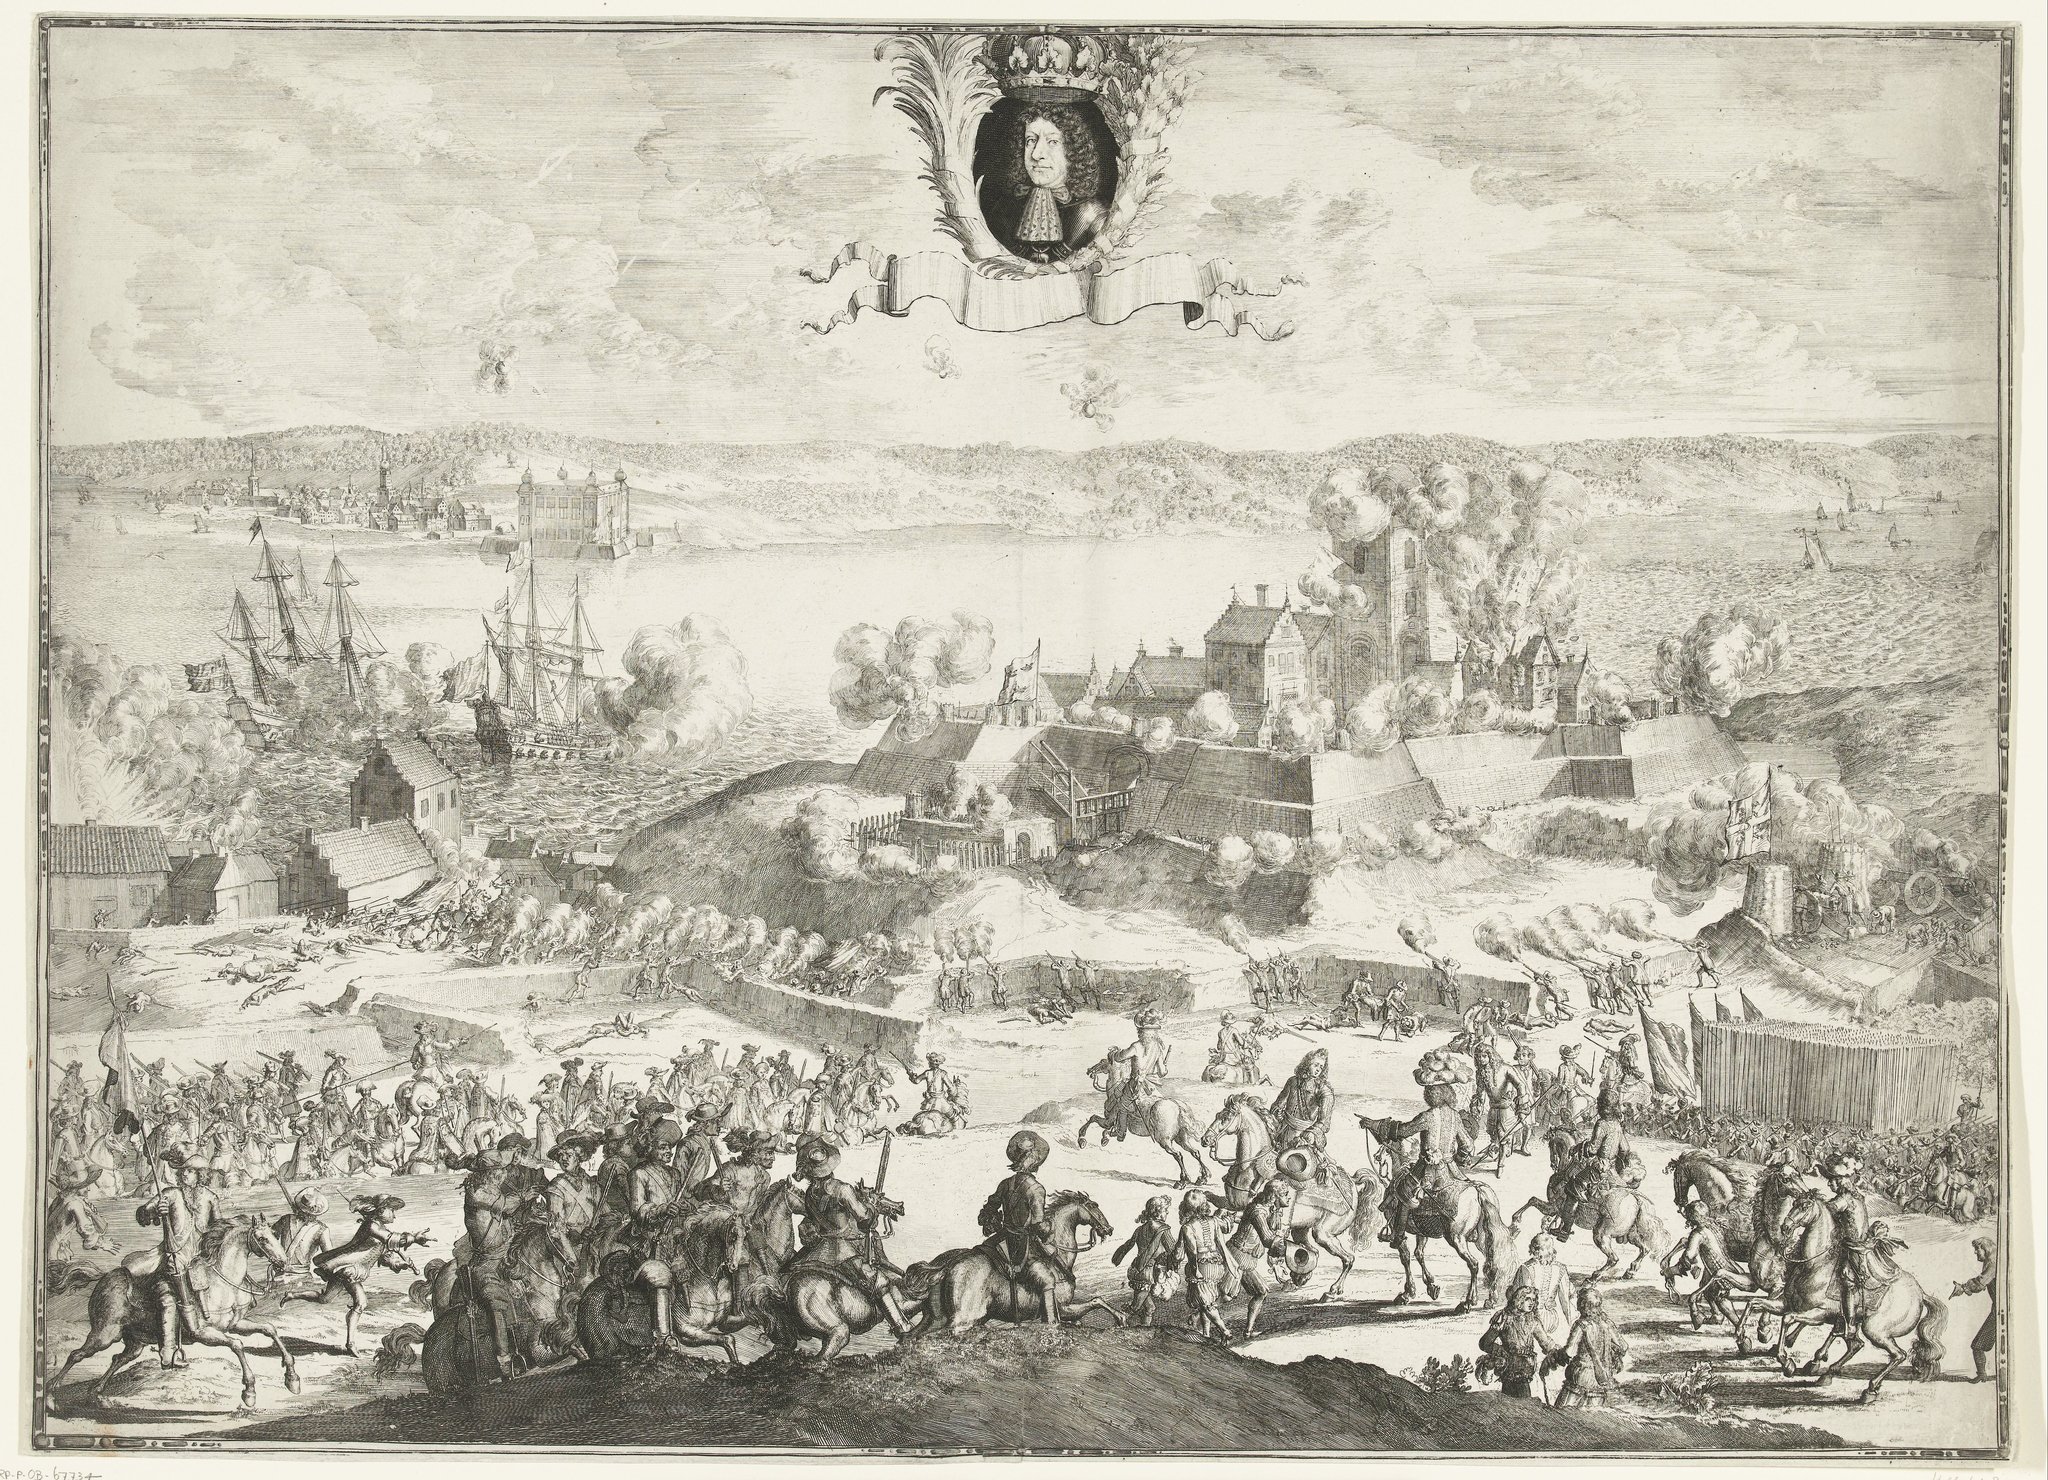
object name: print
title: Verovering van Helsingborg (Elsenburgh) door het Zweedse leger, 1677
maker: romeyn de hooghe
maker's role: draughtsman, goldsmith, painter, print maker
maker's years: 1645-1708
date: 1677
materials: paper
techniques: etching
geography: netherlands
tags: capture of city (after the siege)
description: Verovering van Helsingborg (Elsenburgh) op de Denen door het Zweedse leger, op 16 januari 1677. Op de voorgrond ruiters, daarachter soldaten die de burcht beschieten. Links op zee twee schepen van waaruit geschoten wordt. Midden boven de voorstelling waarschijnlijk een portret van Karel XI van Zweden in een cartouche met lege banderol eronder.